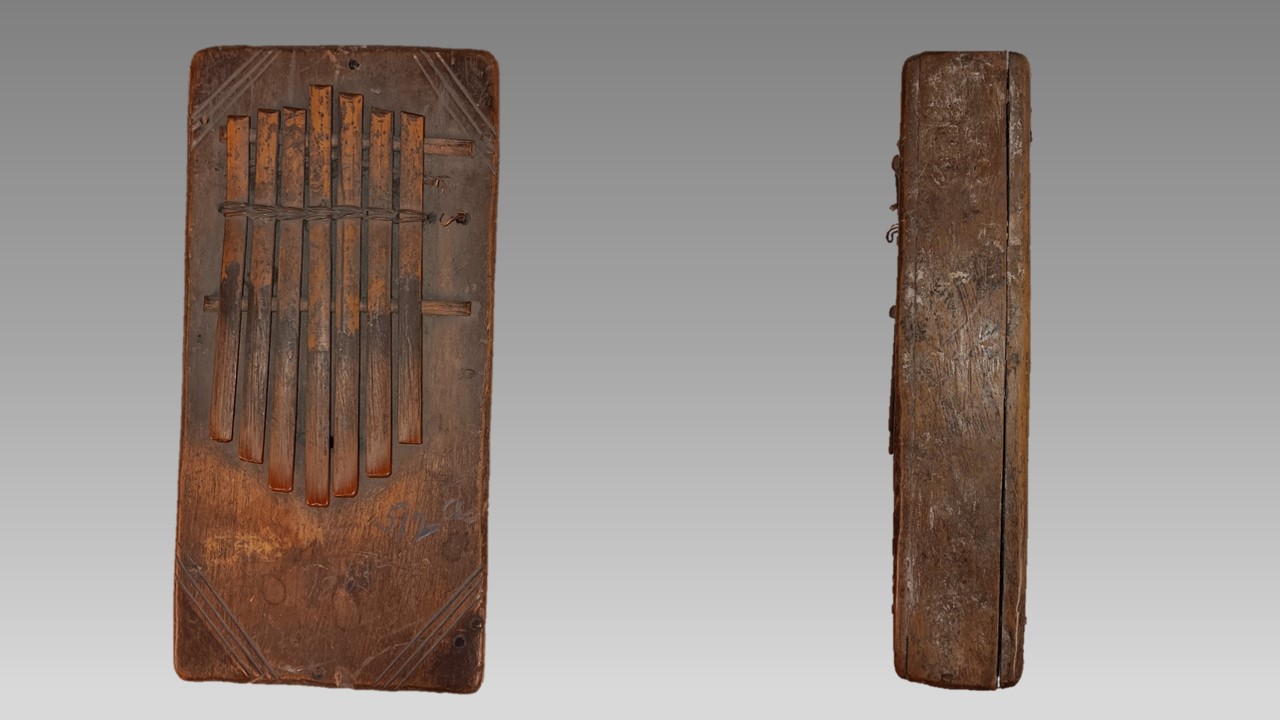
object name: zanze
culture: african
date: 1867-1900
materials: wood